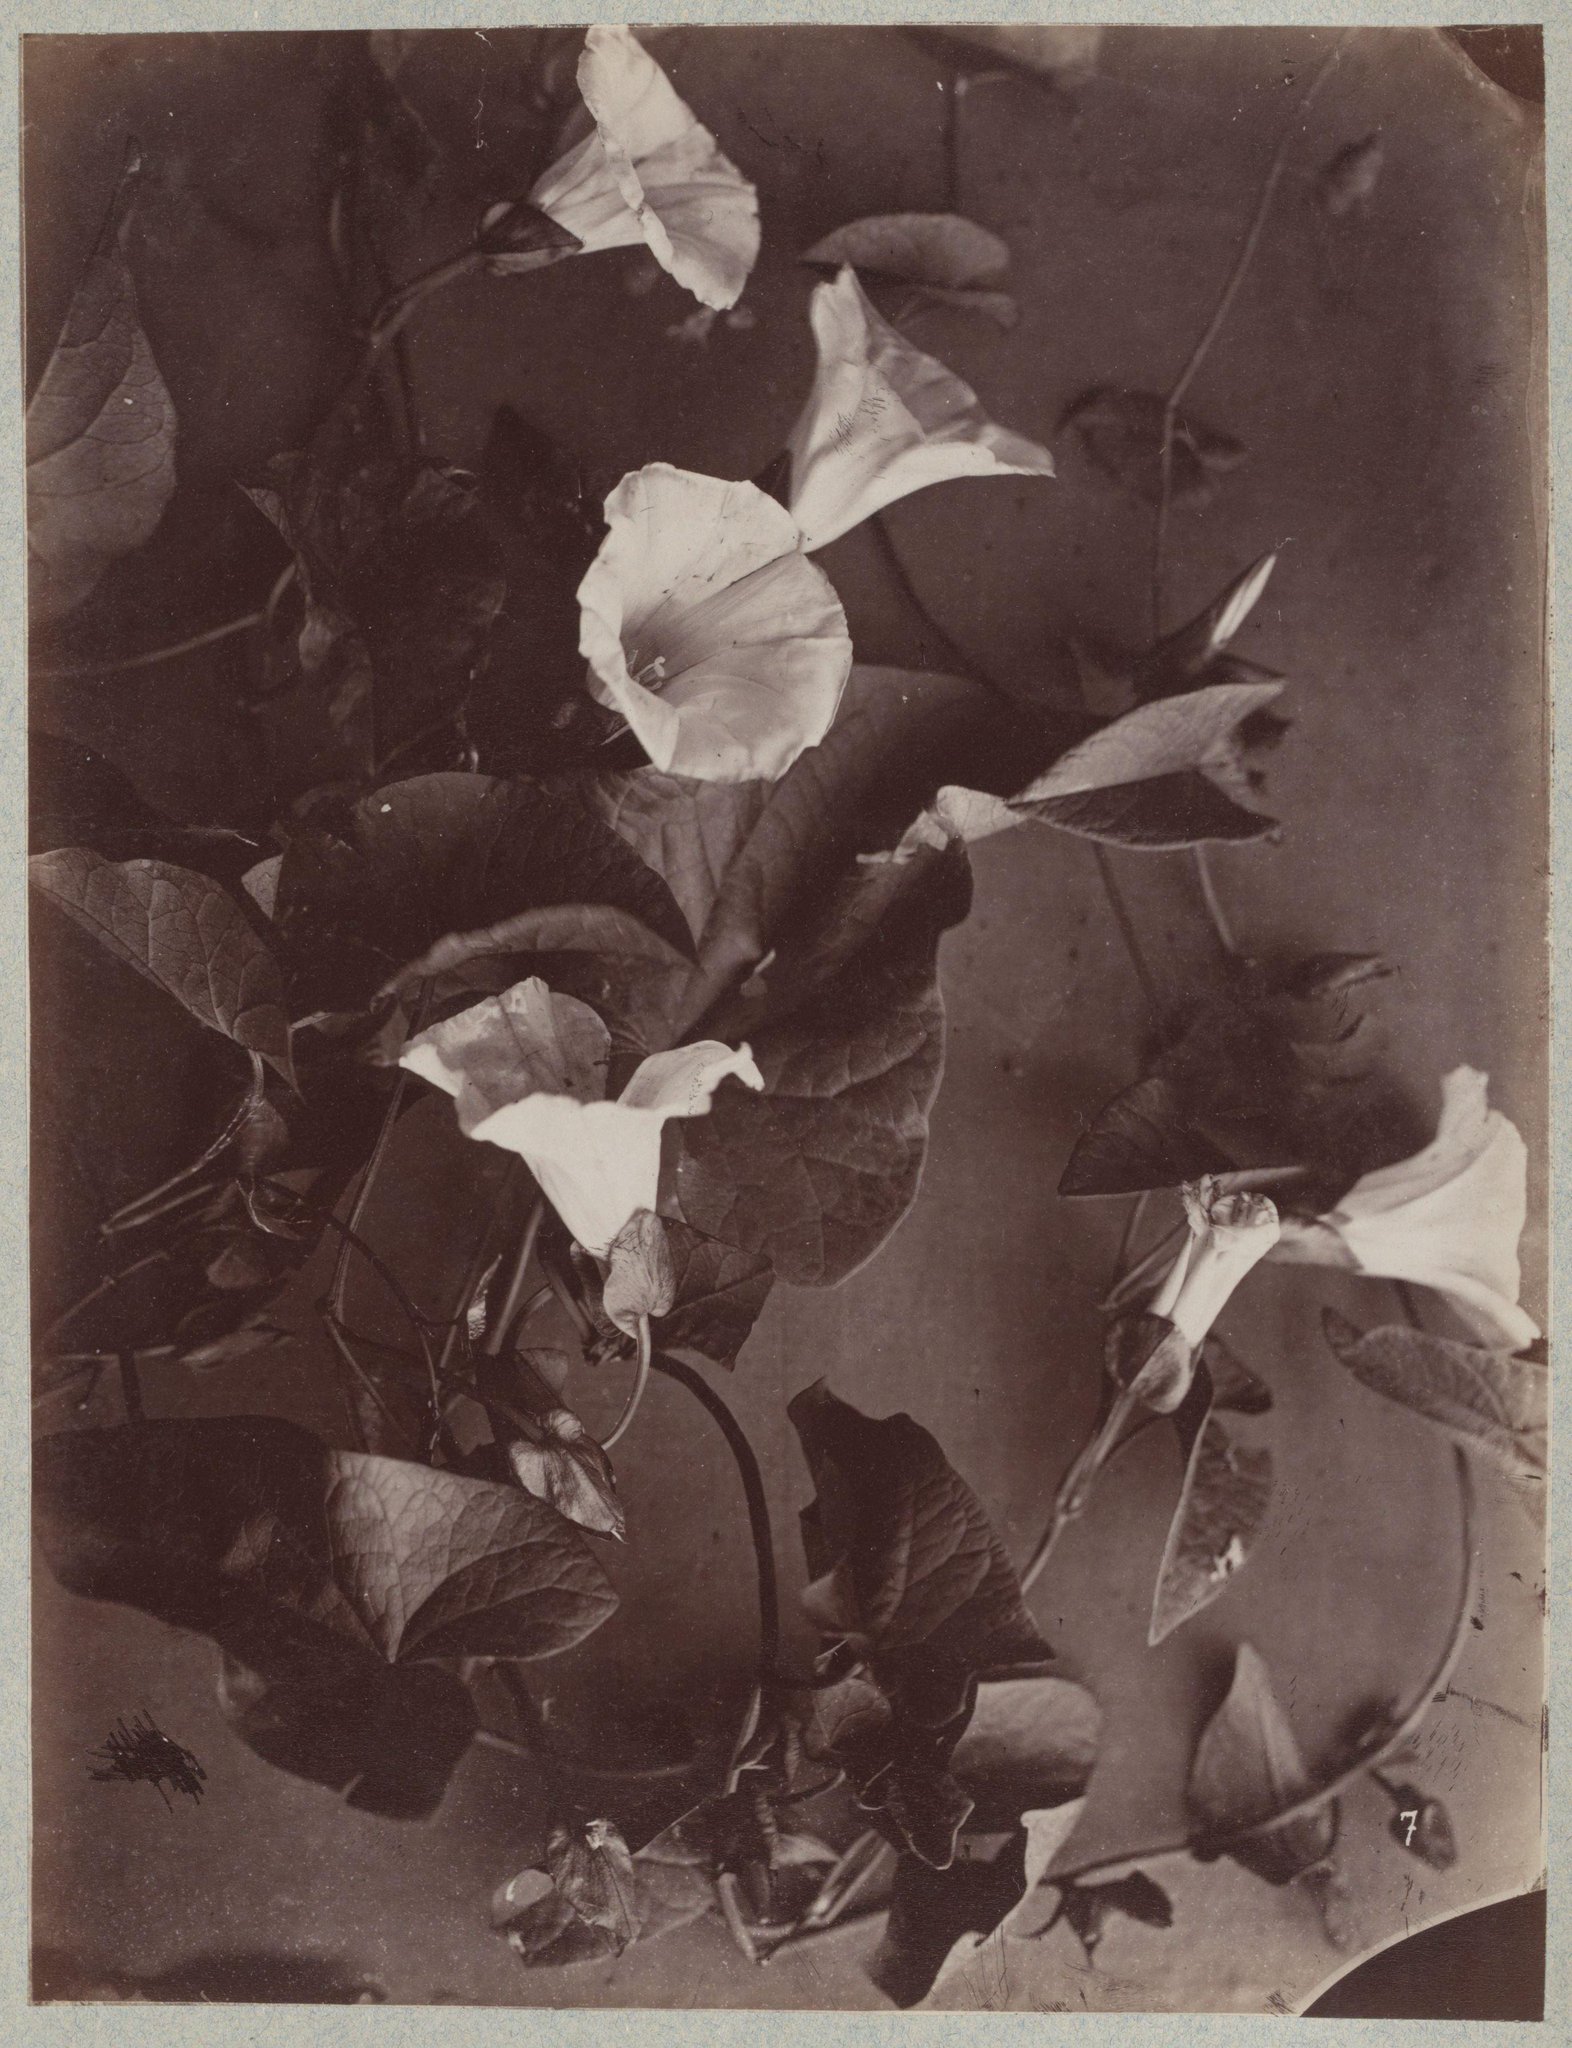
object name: photograph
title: Studies of Plants and Grasses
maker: a. calavas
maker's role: publisher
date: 1885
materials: cardboard, photographic support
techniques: albumen print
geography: paris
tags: flowers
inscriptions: collector's mark: Lugt 3937, number: ‘7’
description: Because photographs were largely considered to be mere aids in the 19th century, the name of the photographer was generally not mentioned. The name on the mounts of these photographs is that of the publisher, the Paris firm of Calavas. From around 1875 it published vast amounts of photographs that were widely used as study material by artists.